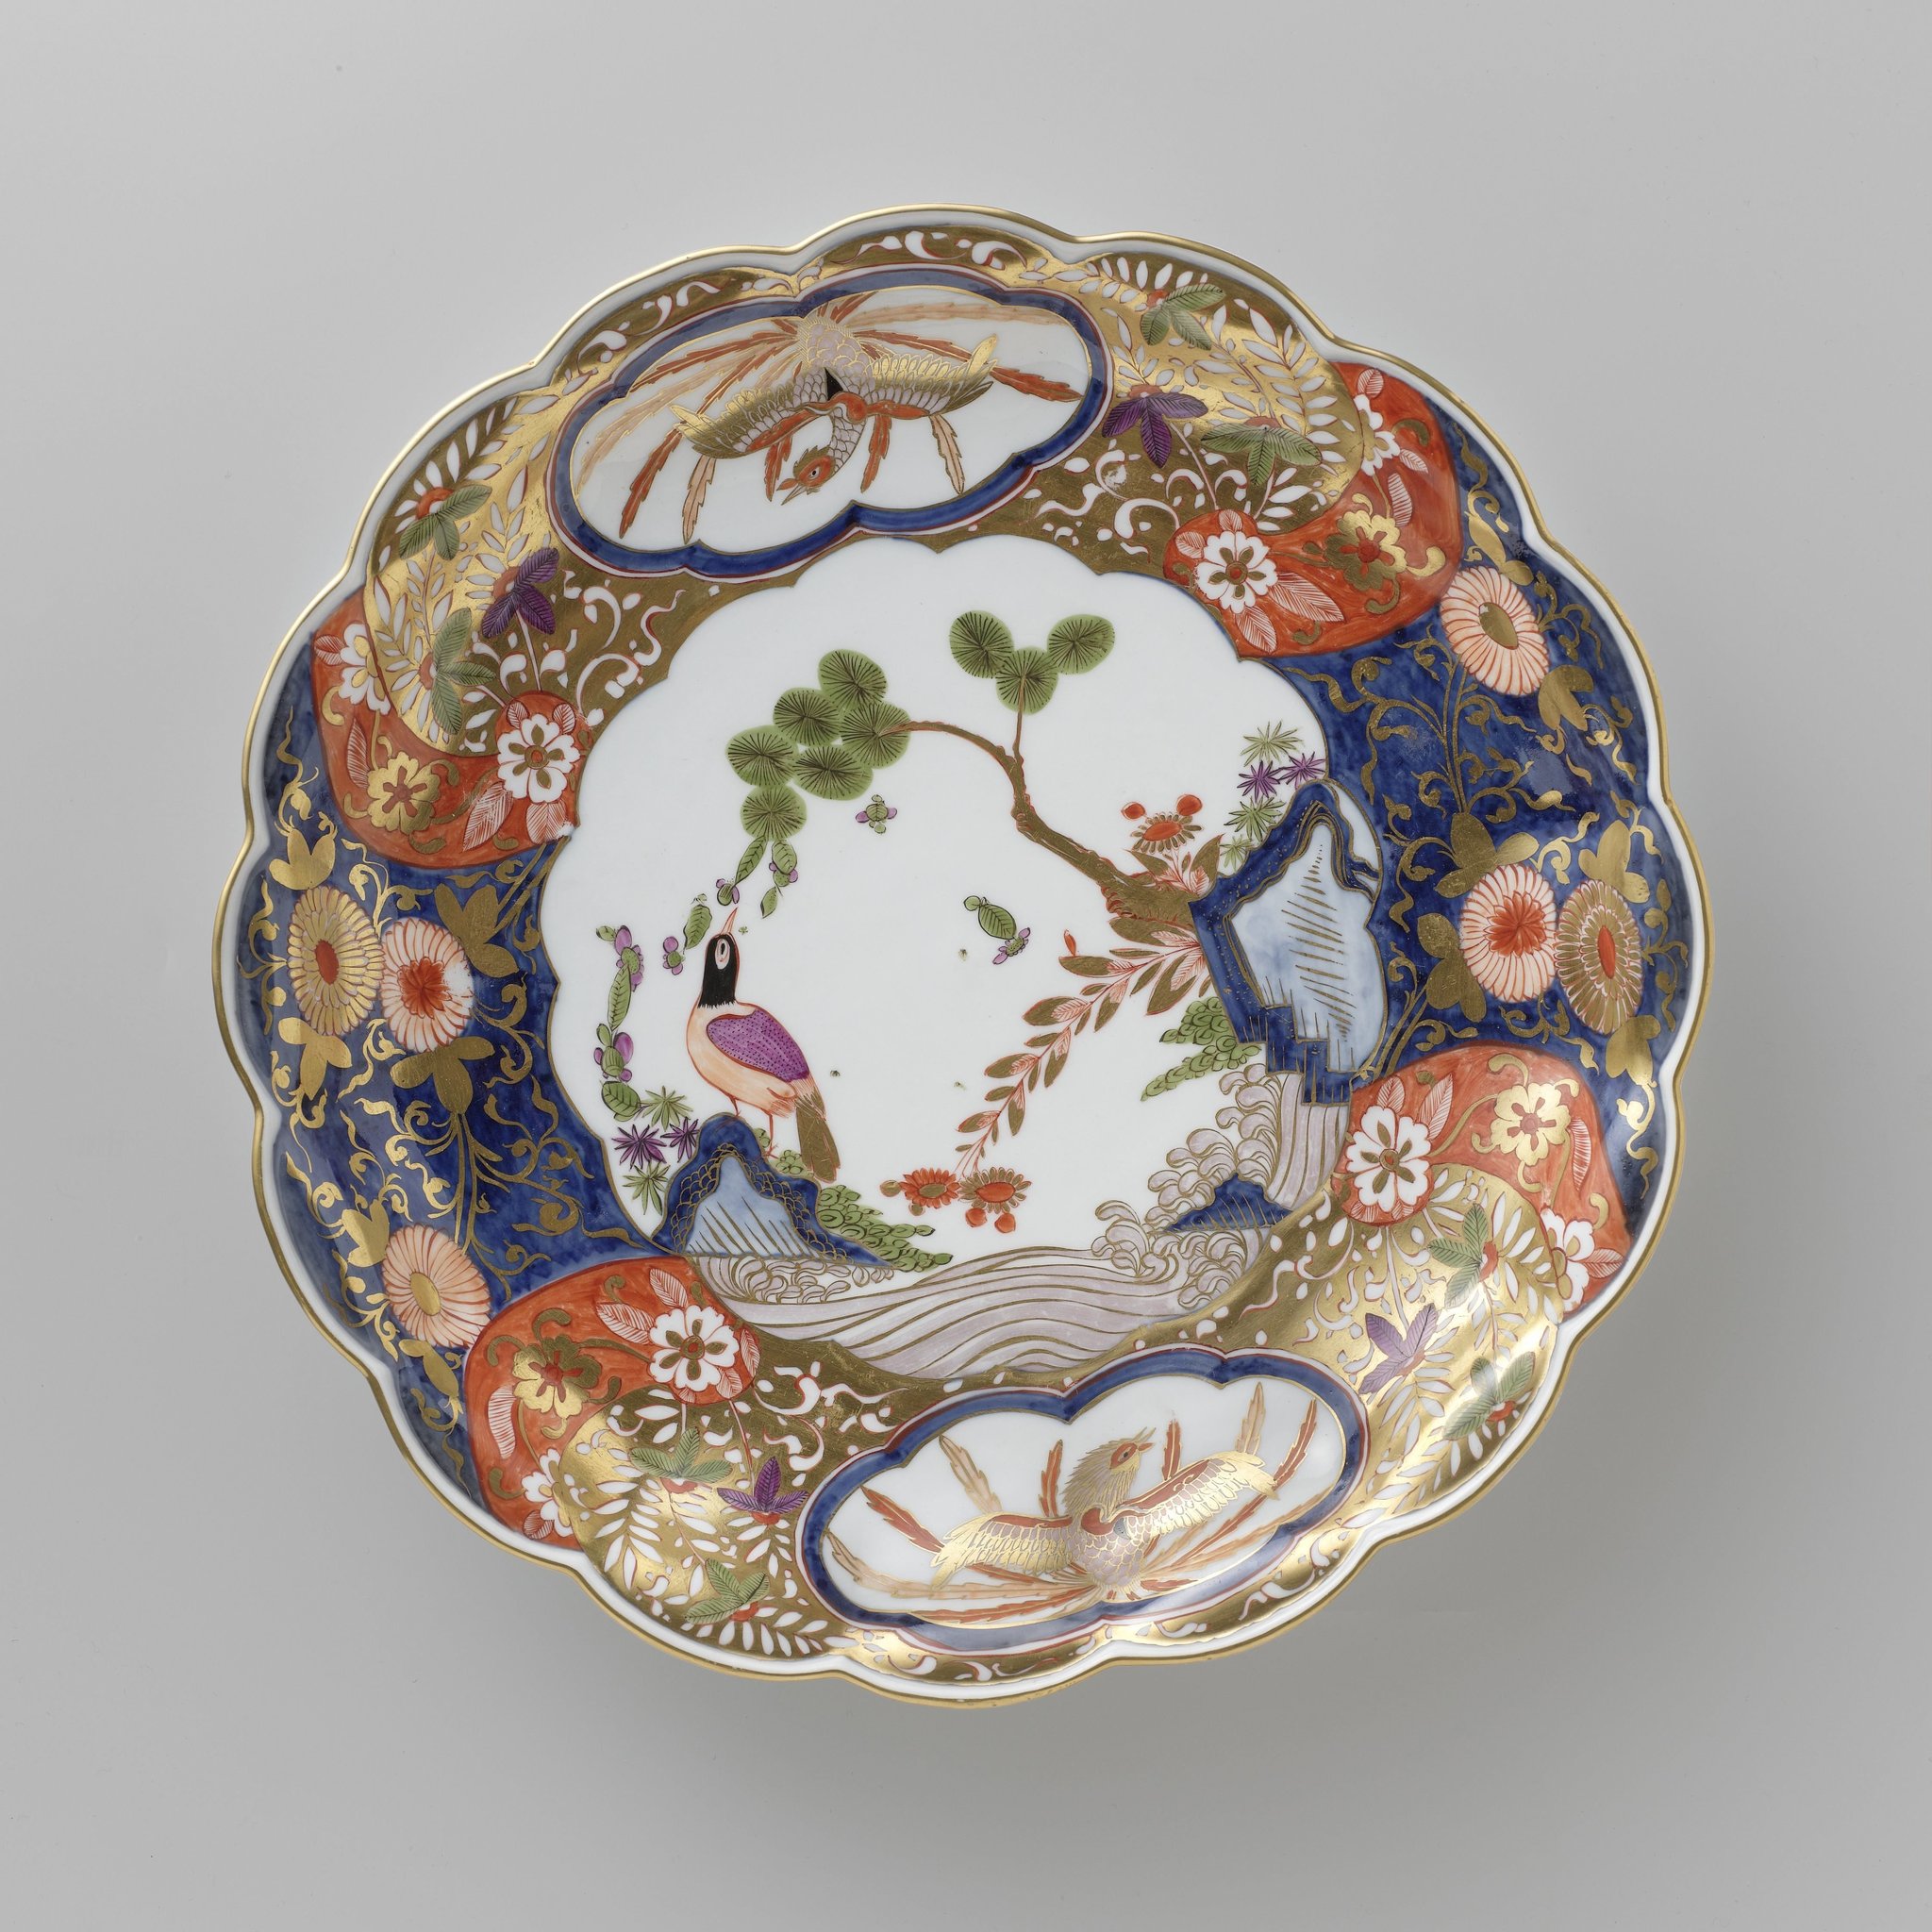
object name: eating drinking utensil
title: Schotel, beschilderd met een Imari-decor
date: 1740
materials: porcelain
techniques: painted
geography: meissen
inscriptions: mold mark: ‘22’, factory mark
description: Dish and plates. Porcelain. Meissen, c. 1740 after a Japanese Imari model.